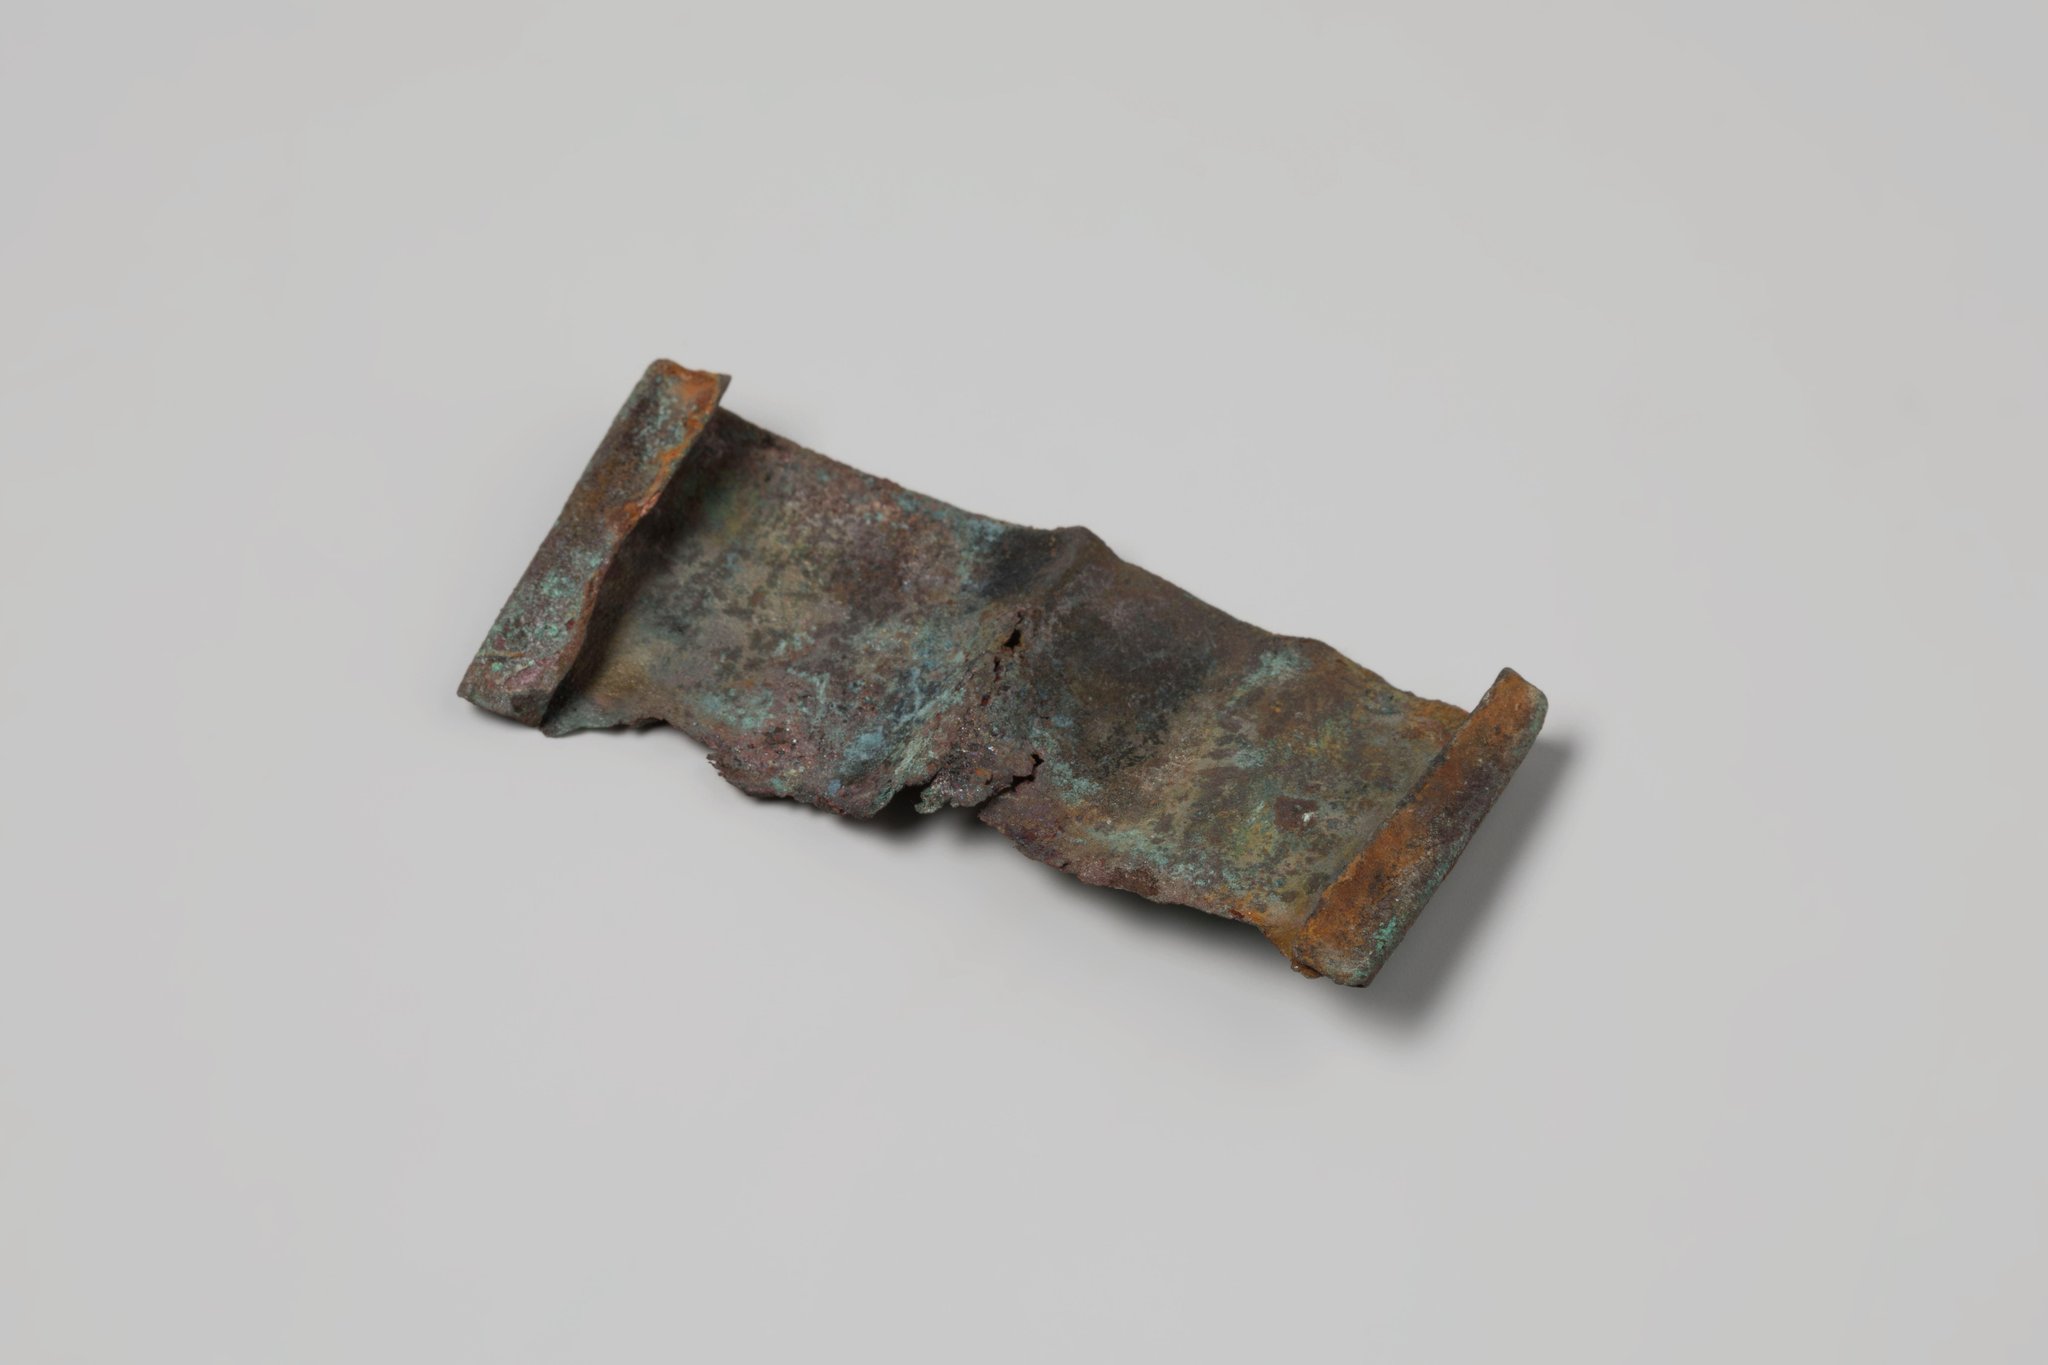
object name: beslag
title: Beslag uit het wrak van de Oost-Indiëvaarder Hollandia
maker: Anonymous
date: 1700-1743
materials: copper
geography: netherlands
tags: verenigde oostindische compagnie, hollandia (schip), annet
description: Fittings, bands and bracing, flat; fragm, eroded, id. NG 1980-27H3053.